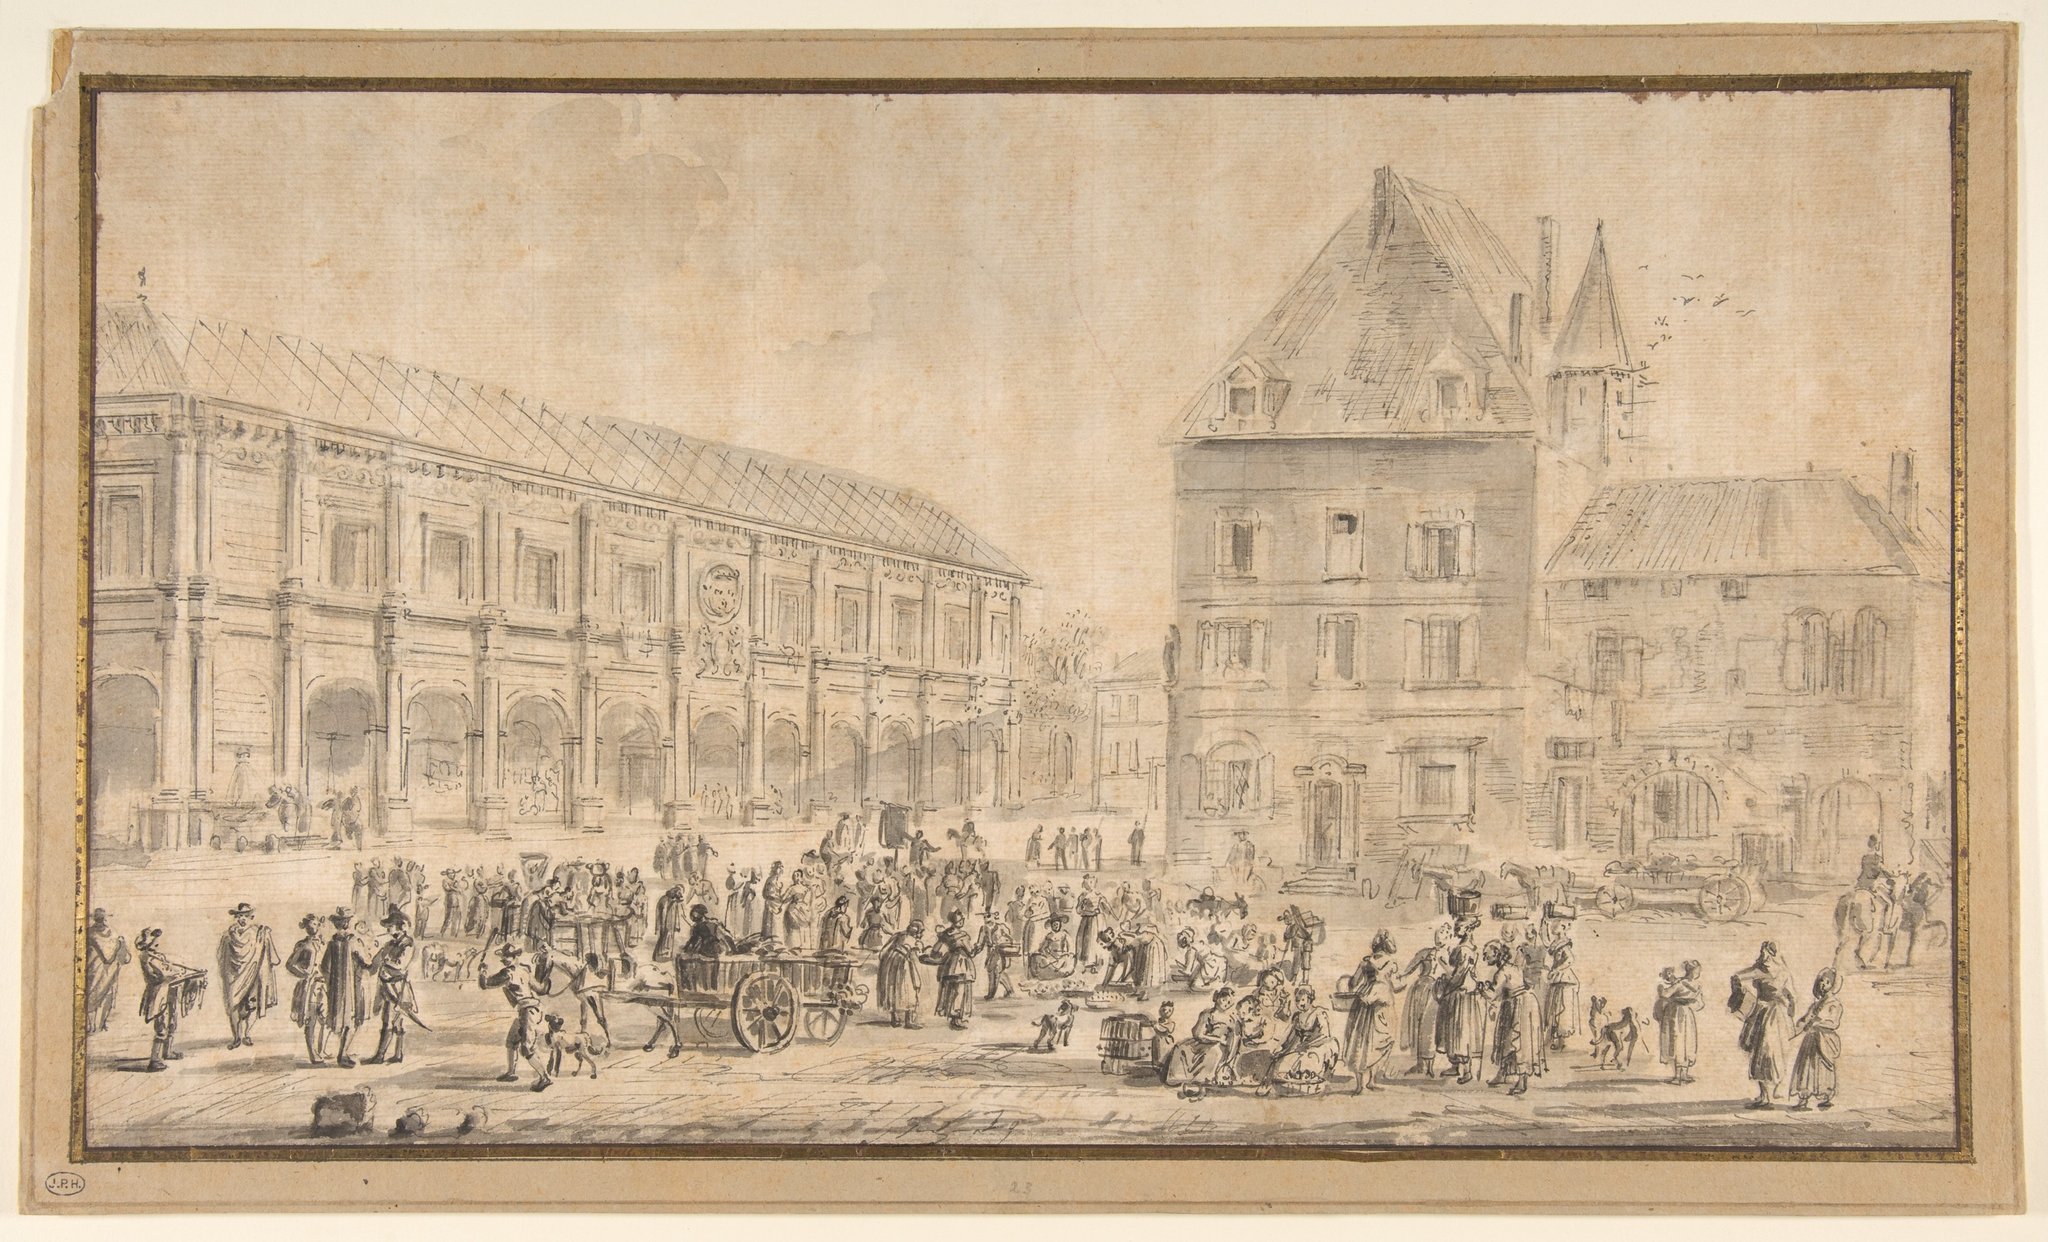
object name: drawing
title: View of Gray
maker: jean-baptiste lallemand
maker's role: artist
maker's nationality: french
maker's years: 1716-1805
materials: chalk, ink, paper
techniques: pen, wash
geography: france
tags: buildings,horses,crowd,street scene